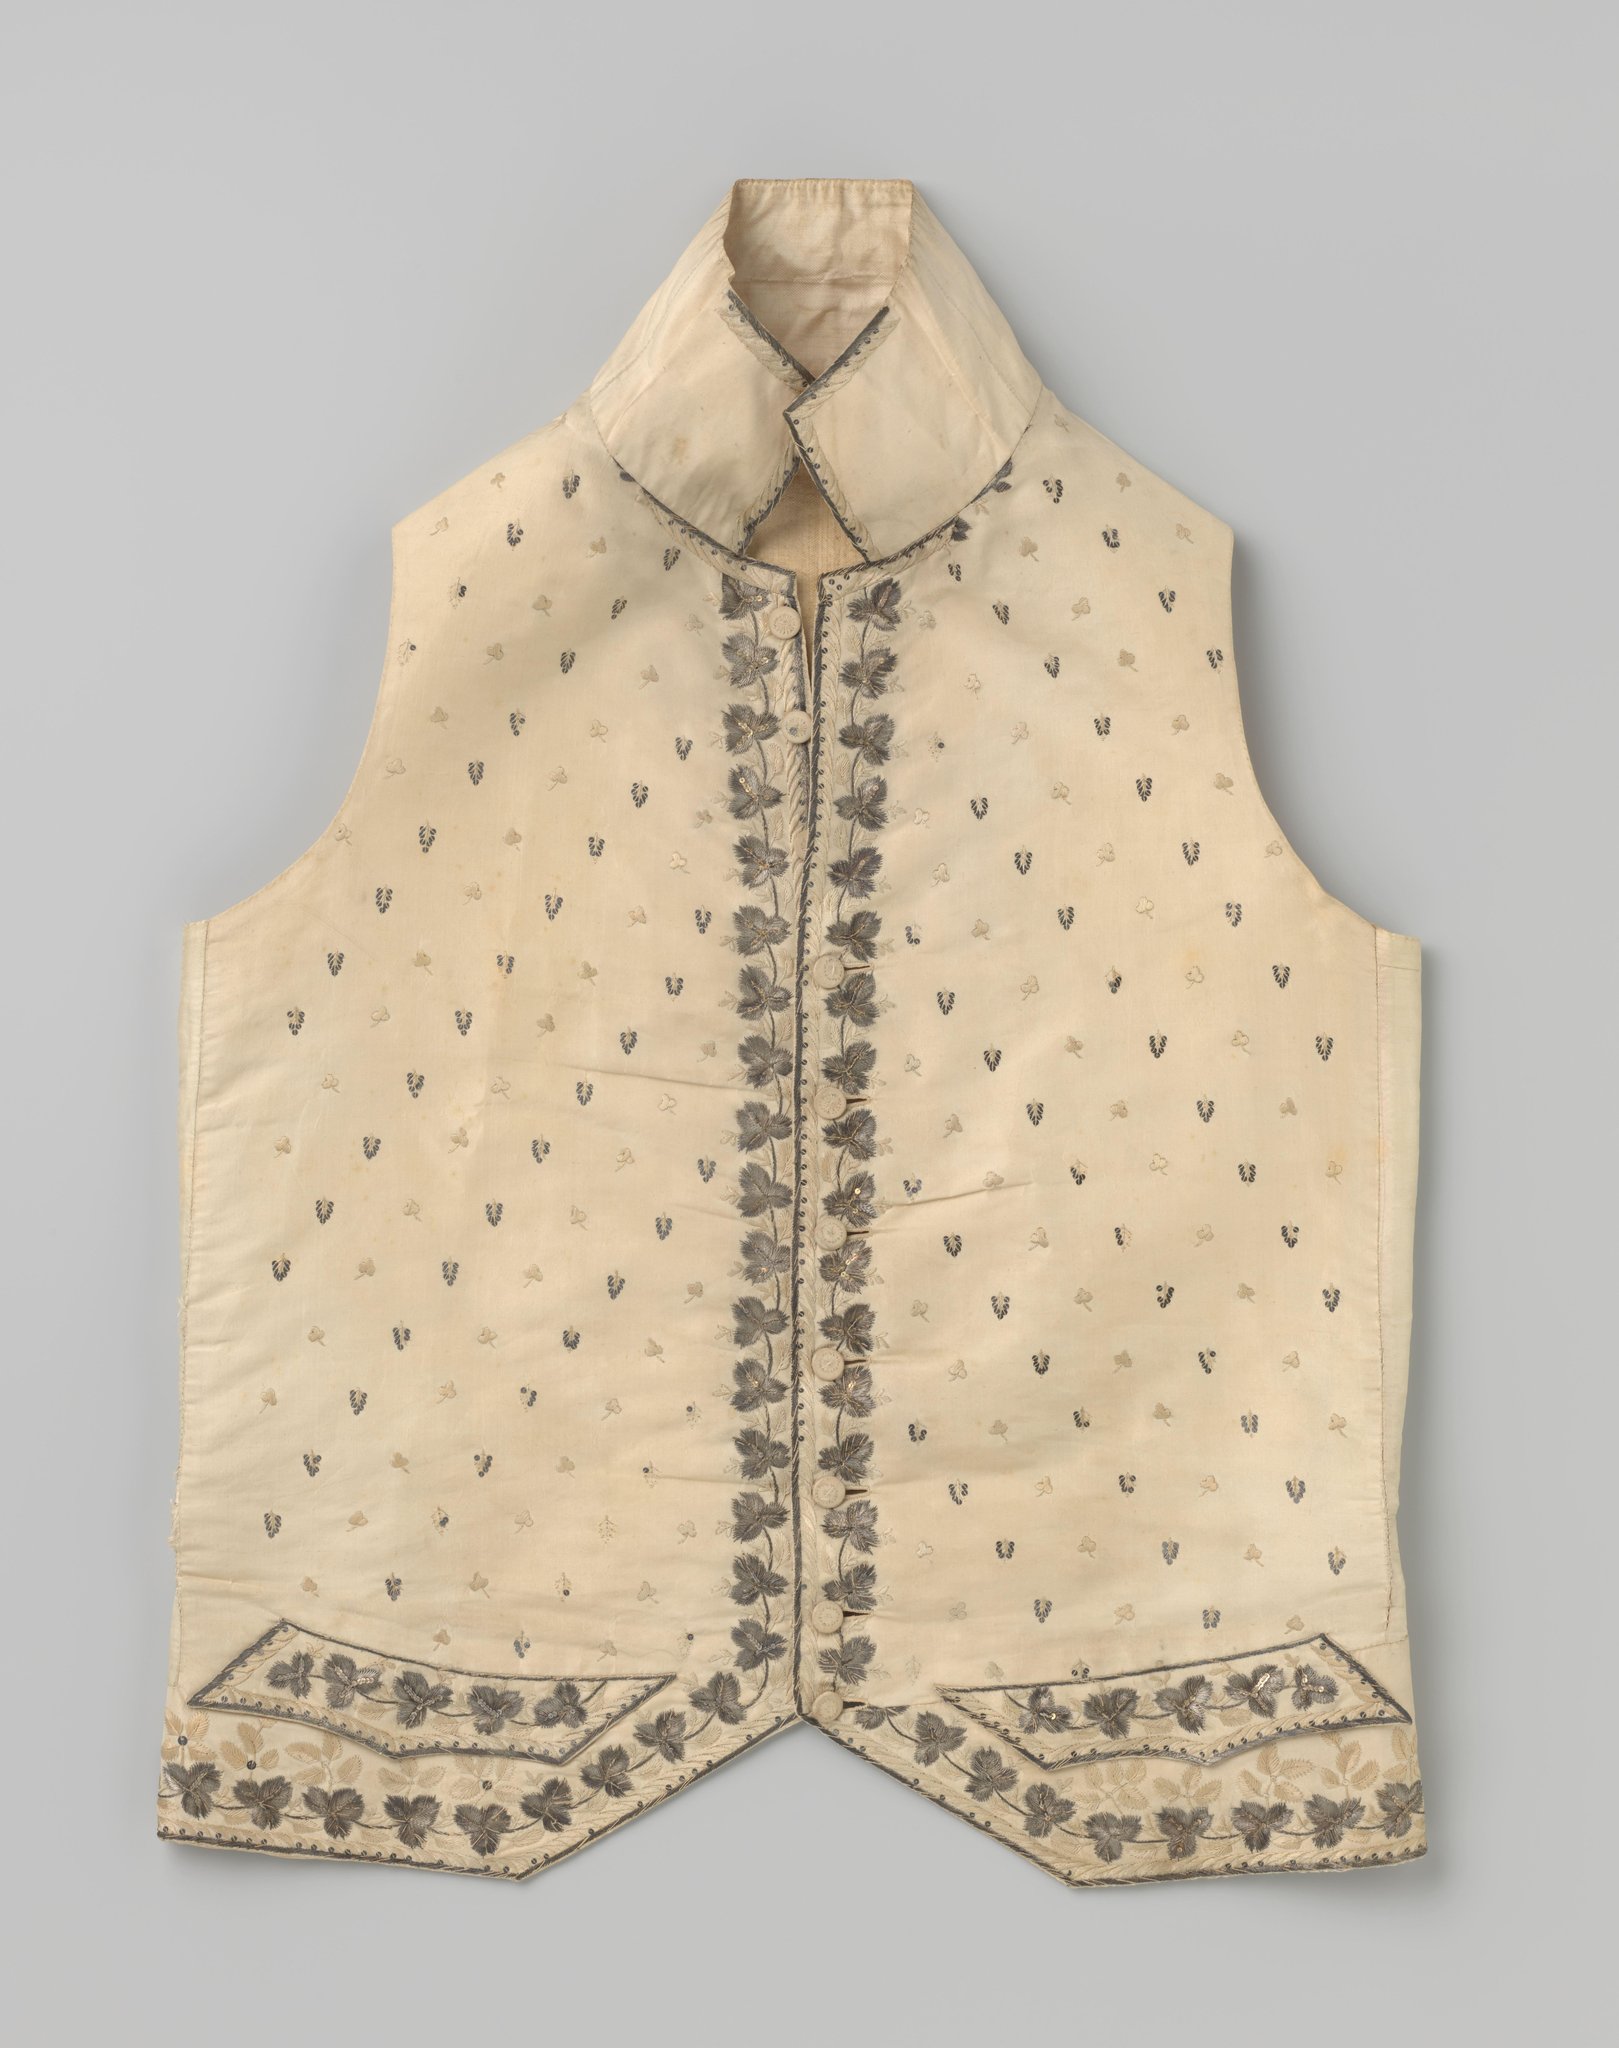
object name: menswear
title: Vest met hoge kraag van witte zijde, versierd met borduurwerk van lichtgele zijde, zilveren pailletten en zilverdraad.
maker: Anonymous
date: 1789-1814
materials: silk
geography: netherlands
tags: vught, overveen, minister, staatsman, secretaris van staat voor financien, minister van financiën, izaak jean alexandre gogel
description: Bij officiele gelegenheden droegen ambtenaren en leden van de regering een ambtskostuum, dat te herkennen is aan de witte bies en voering.